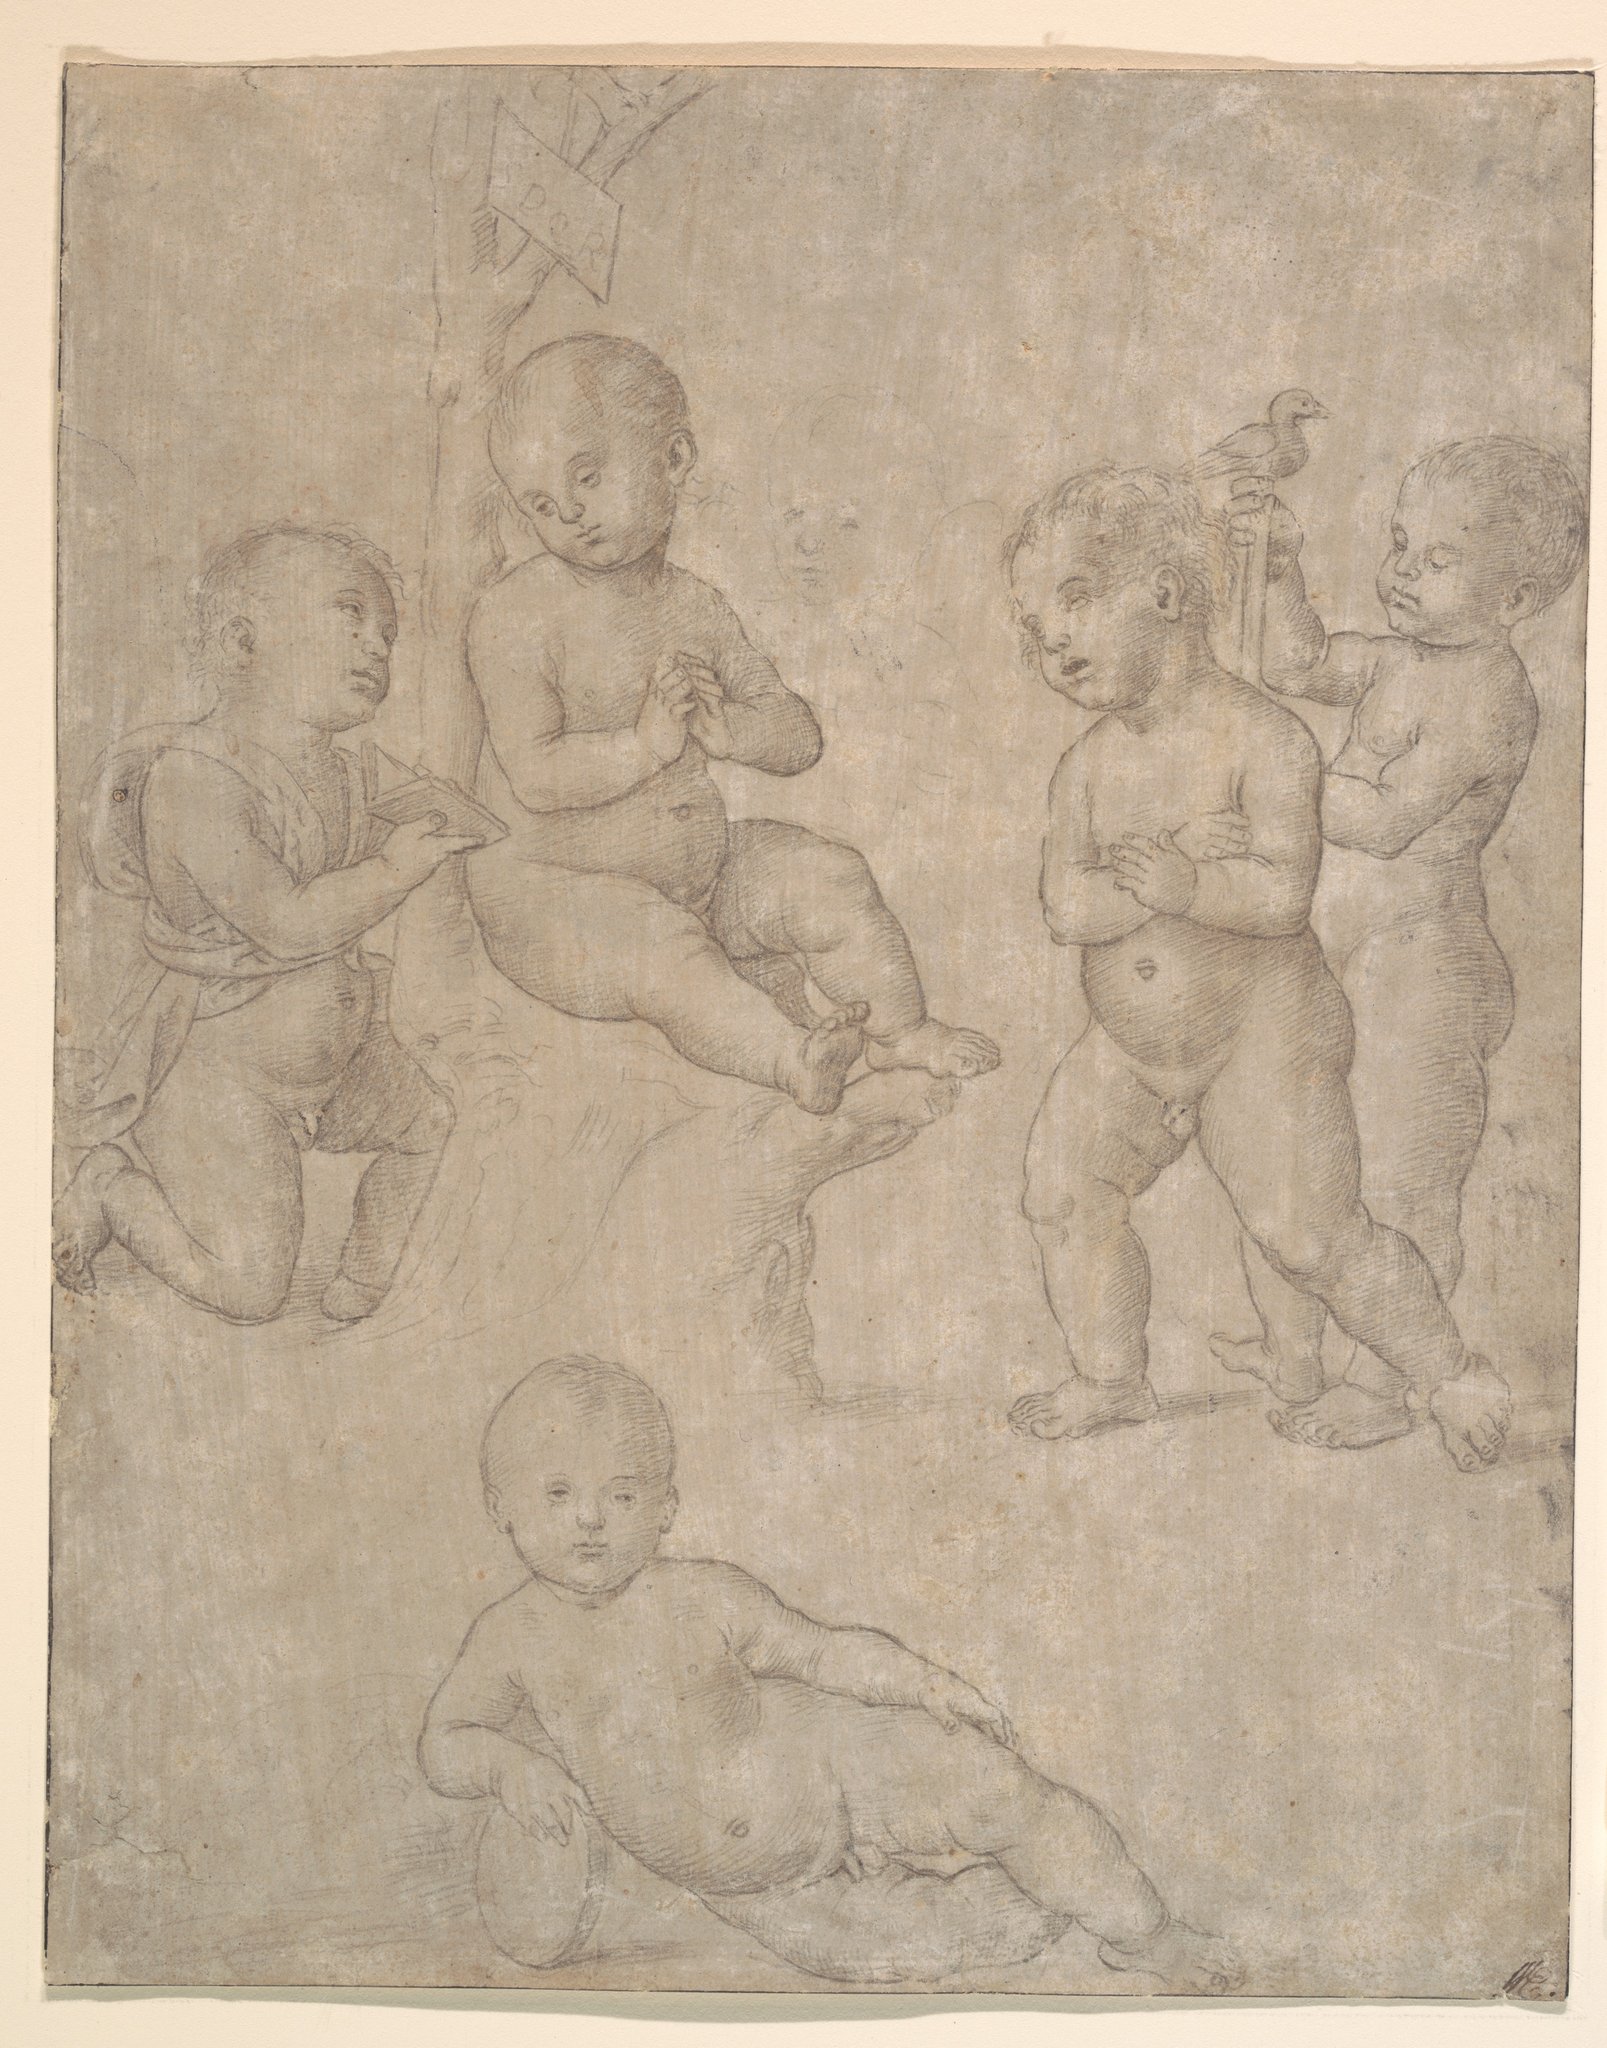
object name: drawing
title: Five Nude Infants in Various Poses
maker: raphael (raffaello sanzio or santi)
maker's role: artist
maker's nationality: italian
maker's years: 1483-1520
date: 1500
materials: chalk, charcoal, paper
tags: infants